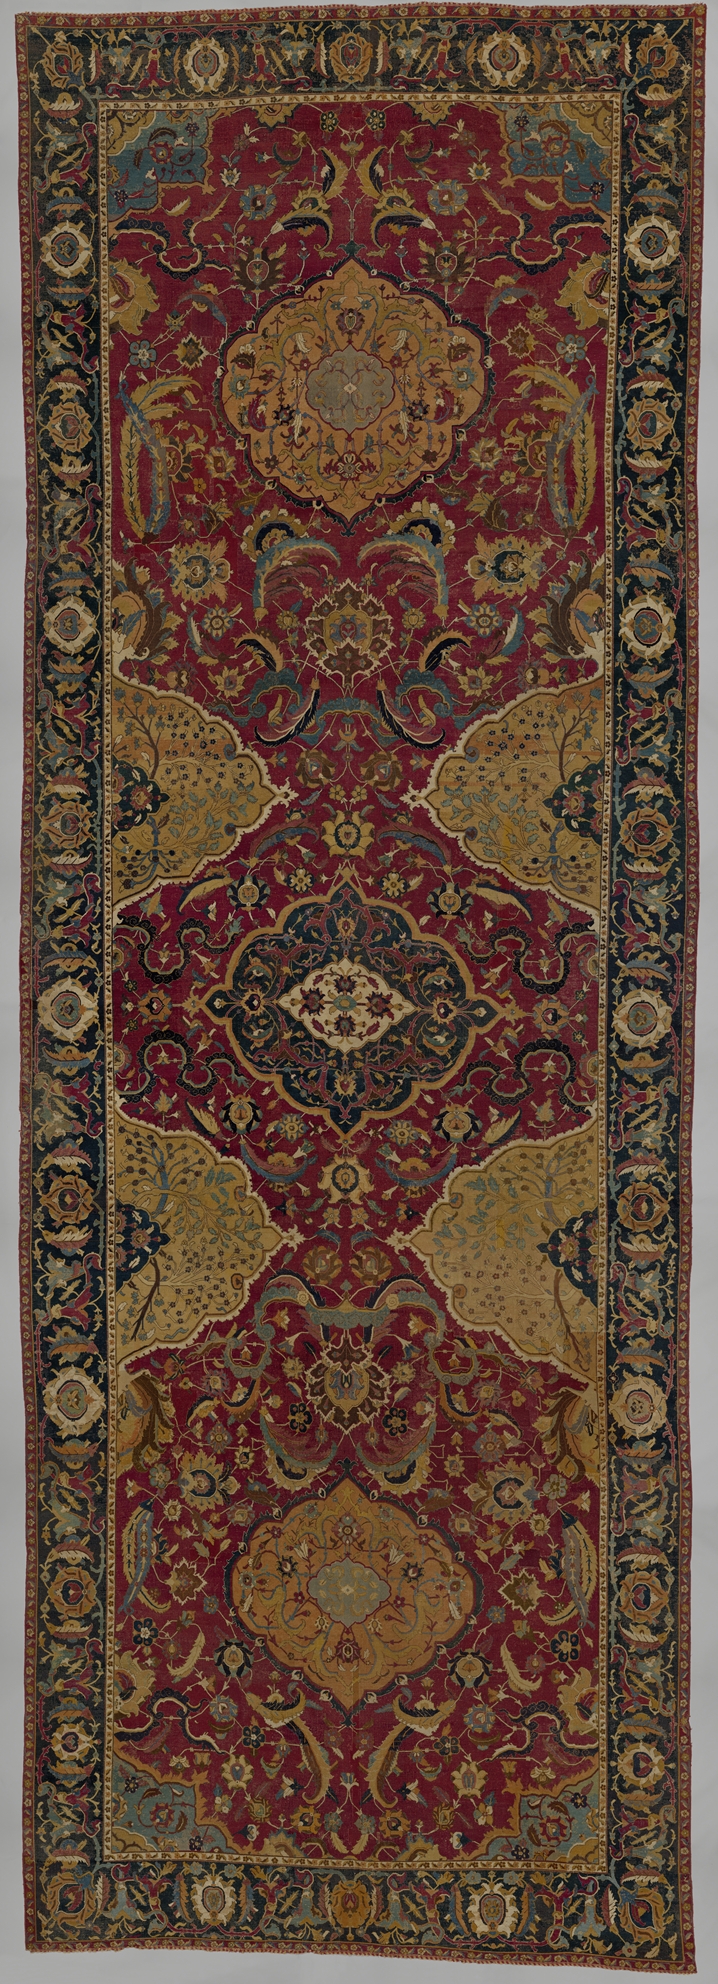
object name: carpet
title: Indo-Persian carpet with medallions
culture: indo-persian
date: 1680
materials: cotton, wool